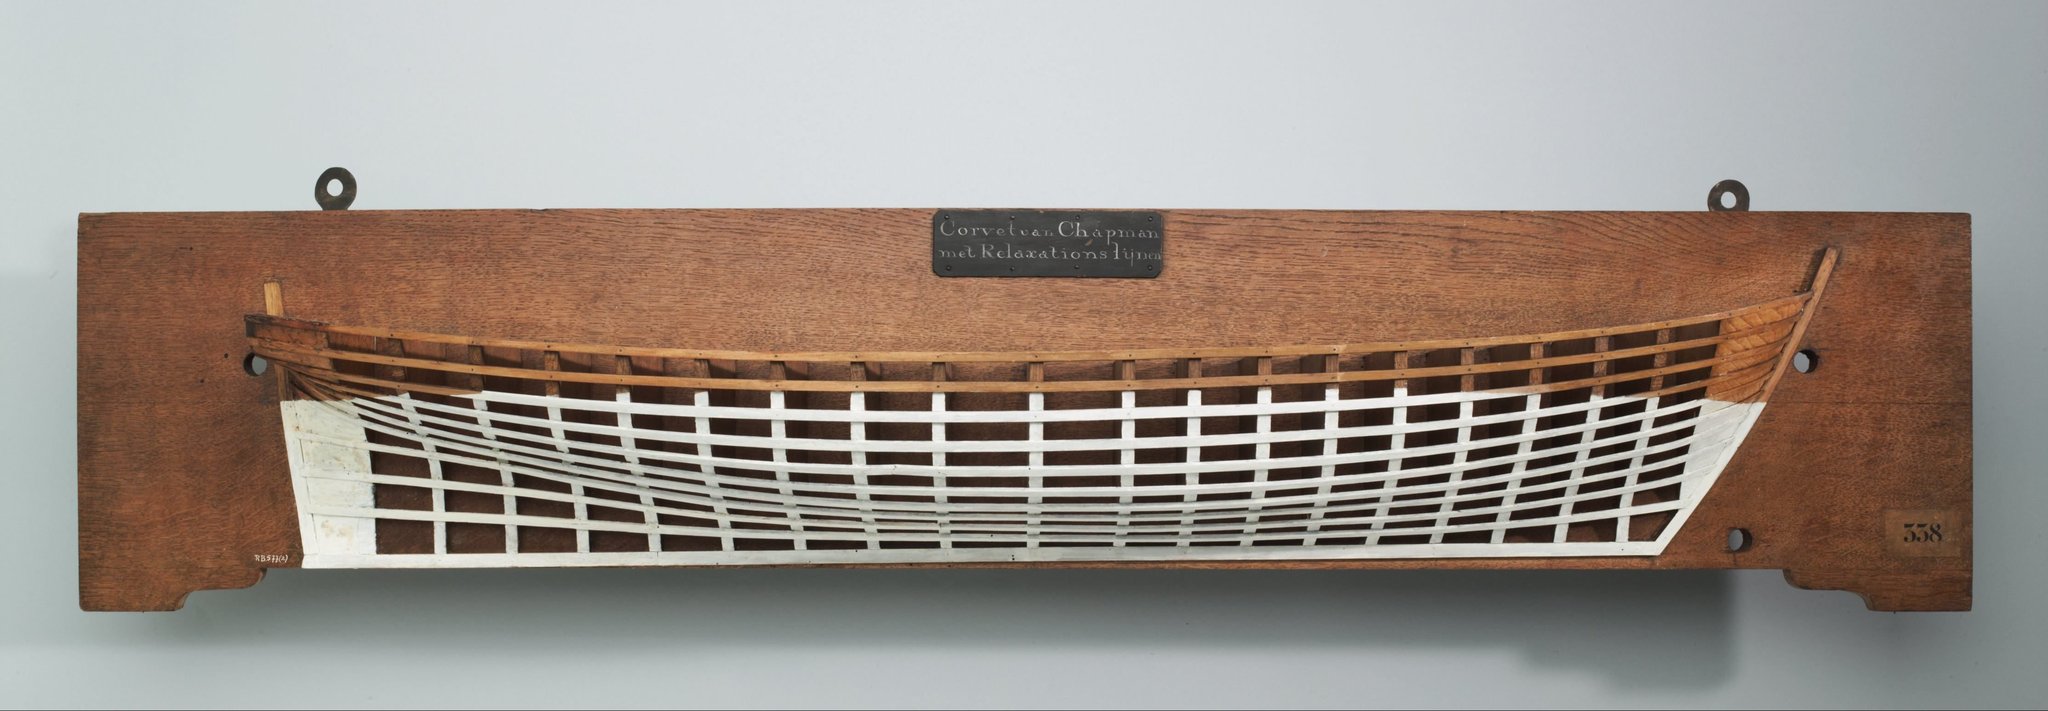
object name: ship model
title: Half Model of a Sloop of War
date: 1765-1800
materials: wood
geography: netherlands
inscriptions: inscription, top centre, on a rectangular black label: ‘CORVET van CHAPMAN met Relaxations lijnen’, label, bottom right: ‘338’ former inventory label, inscription, left from the keel: ‘RB.577(2)’ former inventory markings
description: Mallenmodel (stuurboord), zonder details of tuigaanduiding. Geen geschutpoorten of dekken aangegeven. Gewrongen spiegel, geen wulf, hek, zijgalerij of roer aangegeven. Zeeg naar achter en voor oplopend, geen barkhouten aangegeven. Gepiekt rondspant.